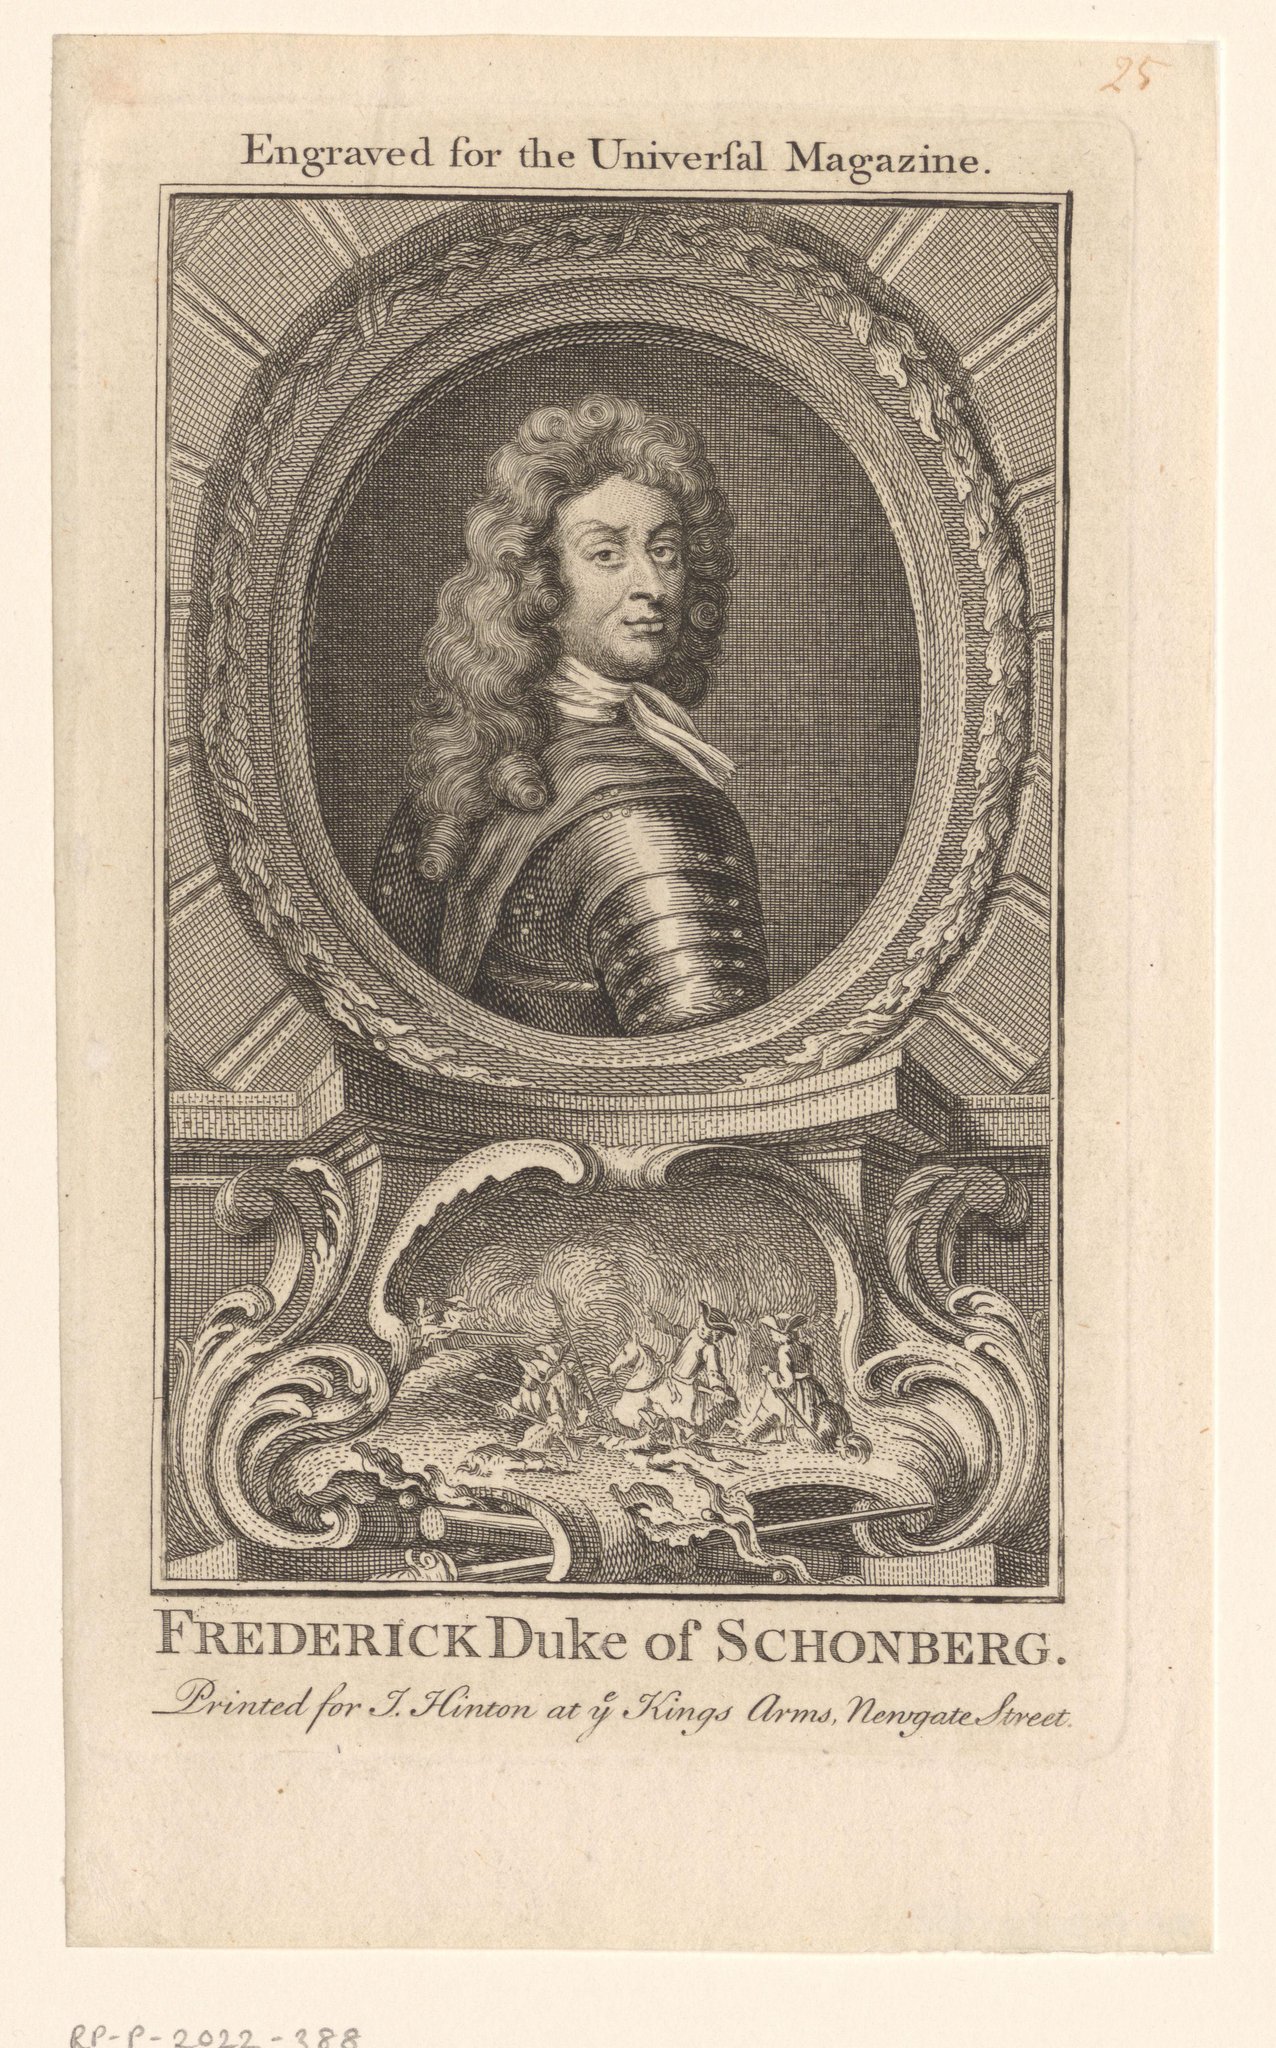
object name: print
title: Portret van hertog Frederik van Schomberg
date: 1761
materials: paper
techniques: engraving, etching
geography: london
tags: commander-in-chief, general, marshal, historical persons, battle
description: Prent waarschijnlijk uit: The Universal Magazine of Knowledge and Pleasure 28 (1761), januari 1761.